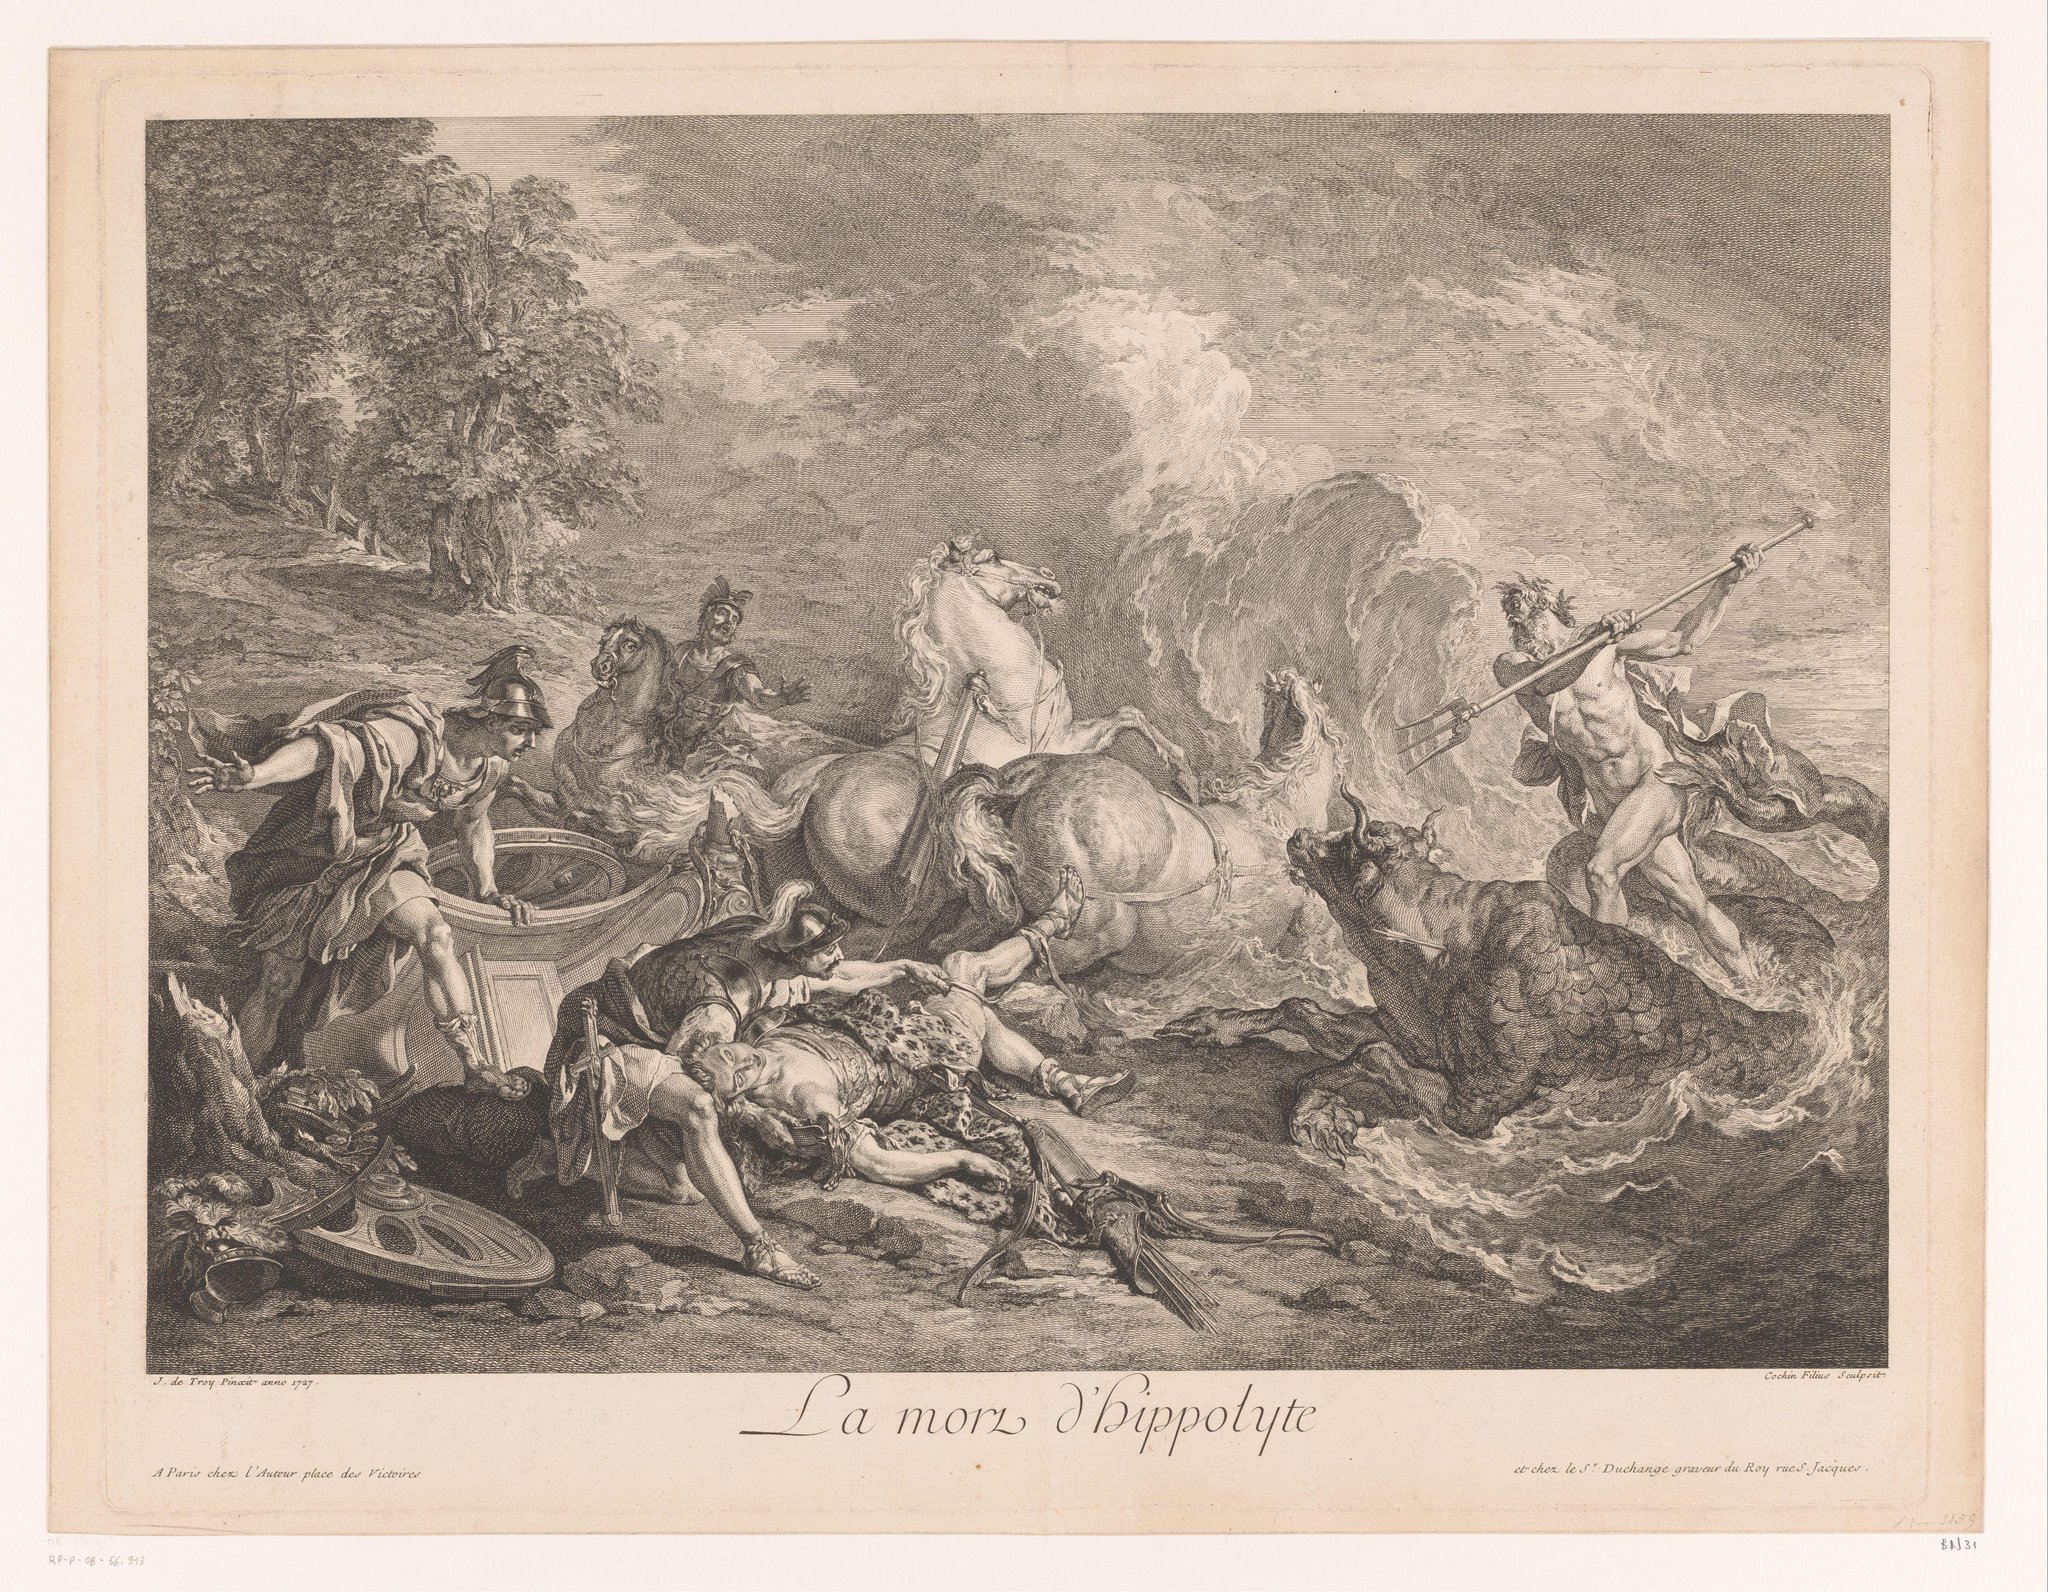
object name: print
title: La mort d'hippolyte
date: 1705-1735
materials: paper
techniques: engraving, etching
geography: paris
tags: death of hippolytus: he is killed when the horses that draw his chariot bolt at the sight of a bull-shaped monster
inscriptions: collector's mark: Lugt 240